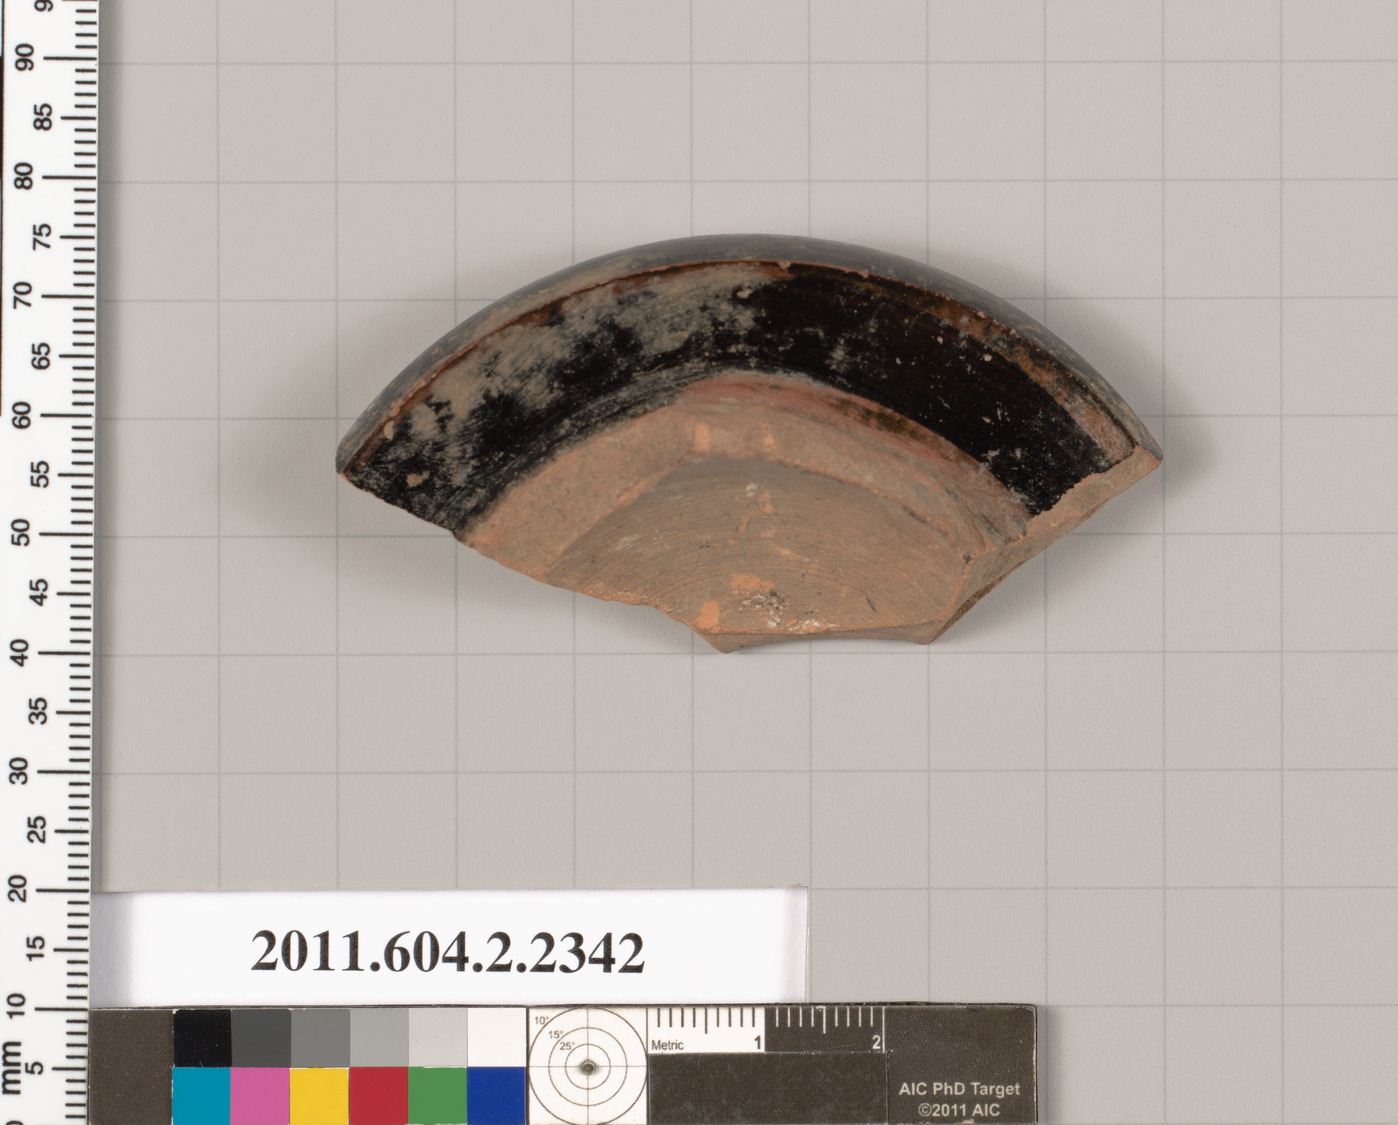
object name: oinochoe fragment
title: Terracotta fragment of an oinochoe (jug)?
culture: greek, attic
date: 600-401 BCE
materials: terracotta